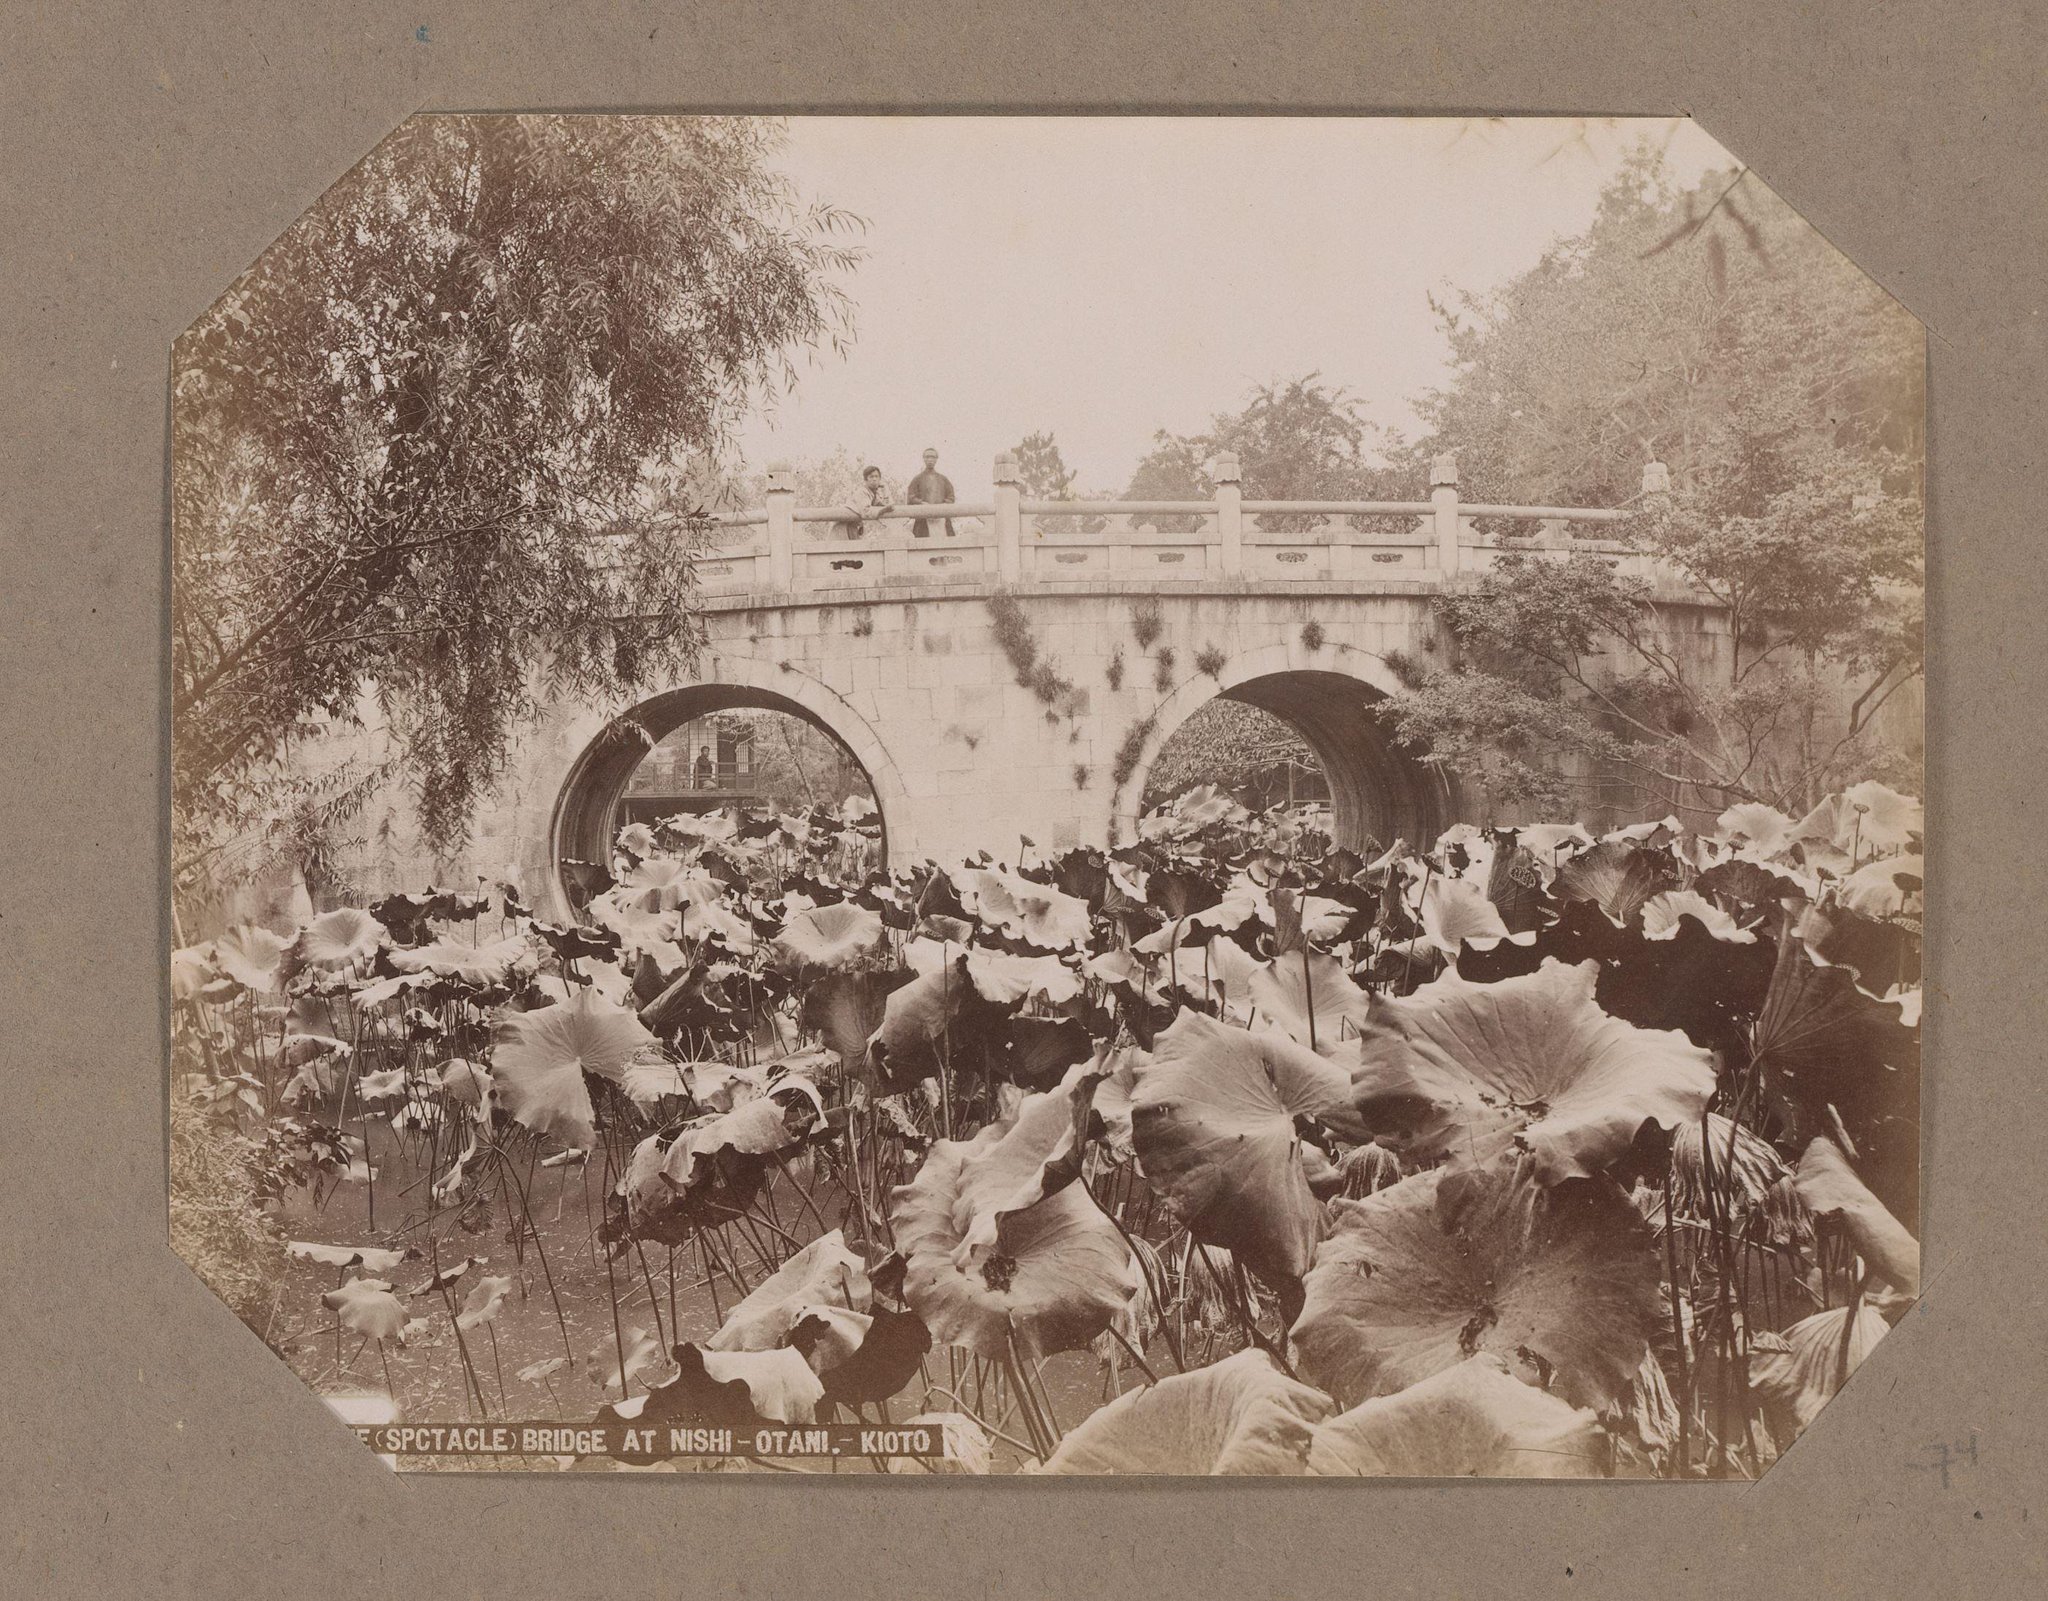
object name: photograph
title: Brug in Nishi Otani, Kyoto, Japan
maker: Anonymous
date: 1890-1903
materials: paper, photographic support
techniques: albumen print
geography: kyoto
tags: plants; vegetation, bridge (+ number of persons ~ traffic and transport), kyoto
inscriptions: inscription: ‘74. Megane (Sp[e]ctacle) Bridge At Nishi - Otani - Kioto’